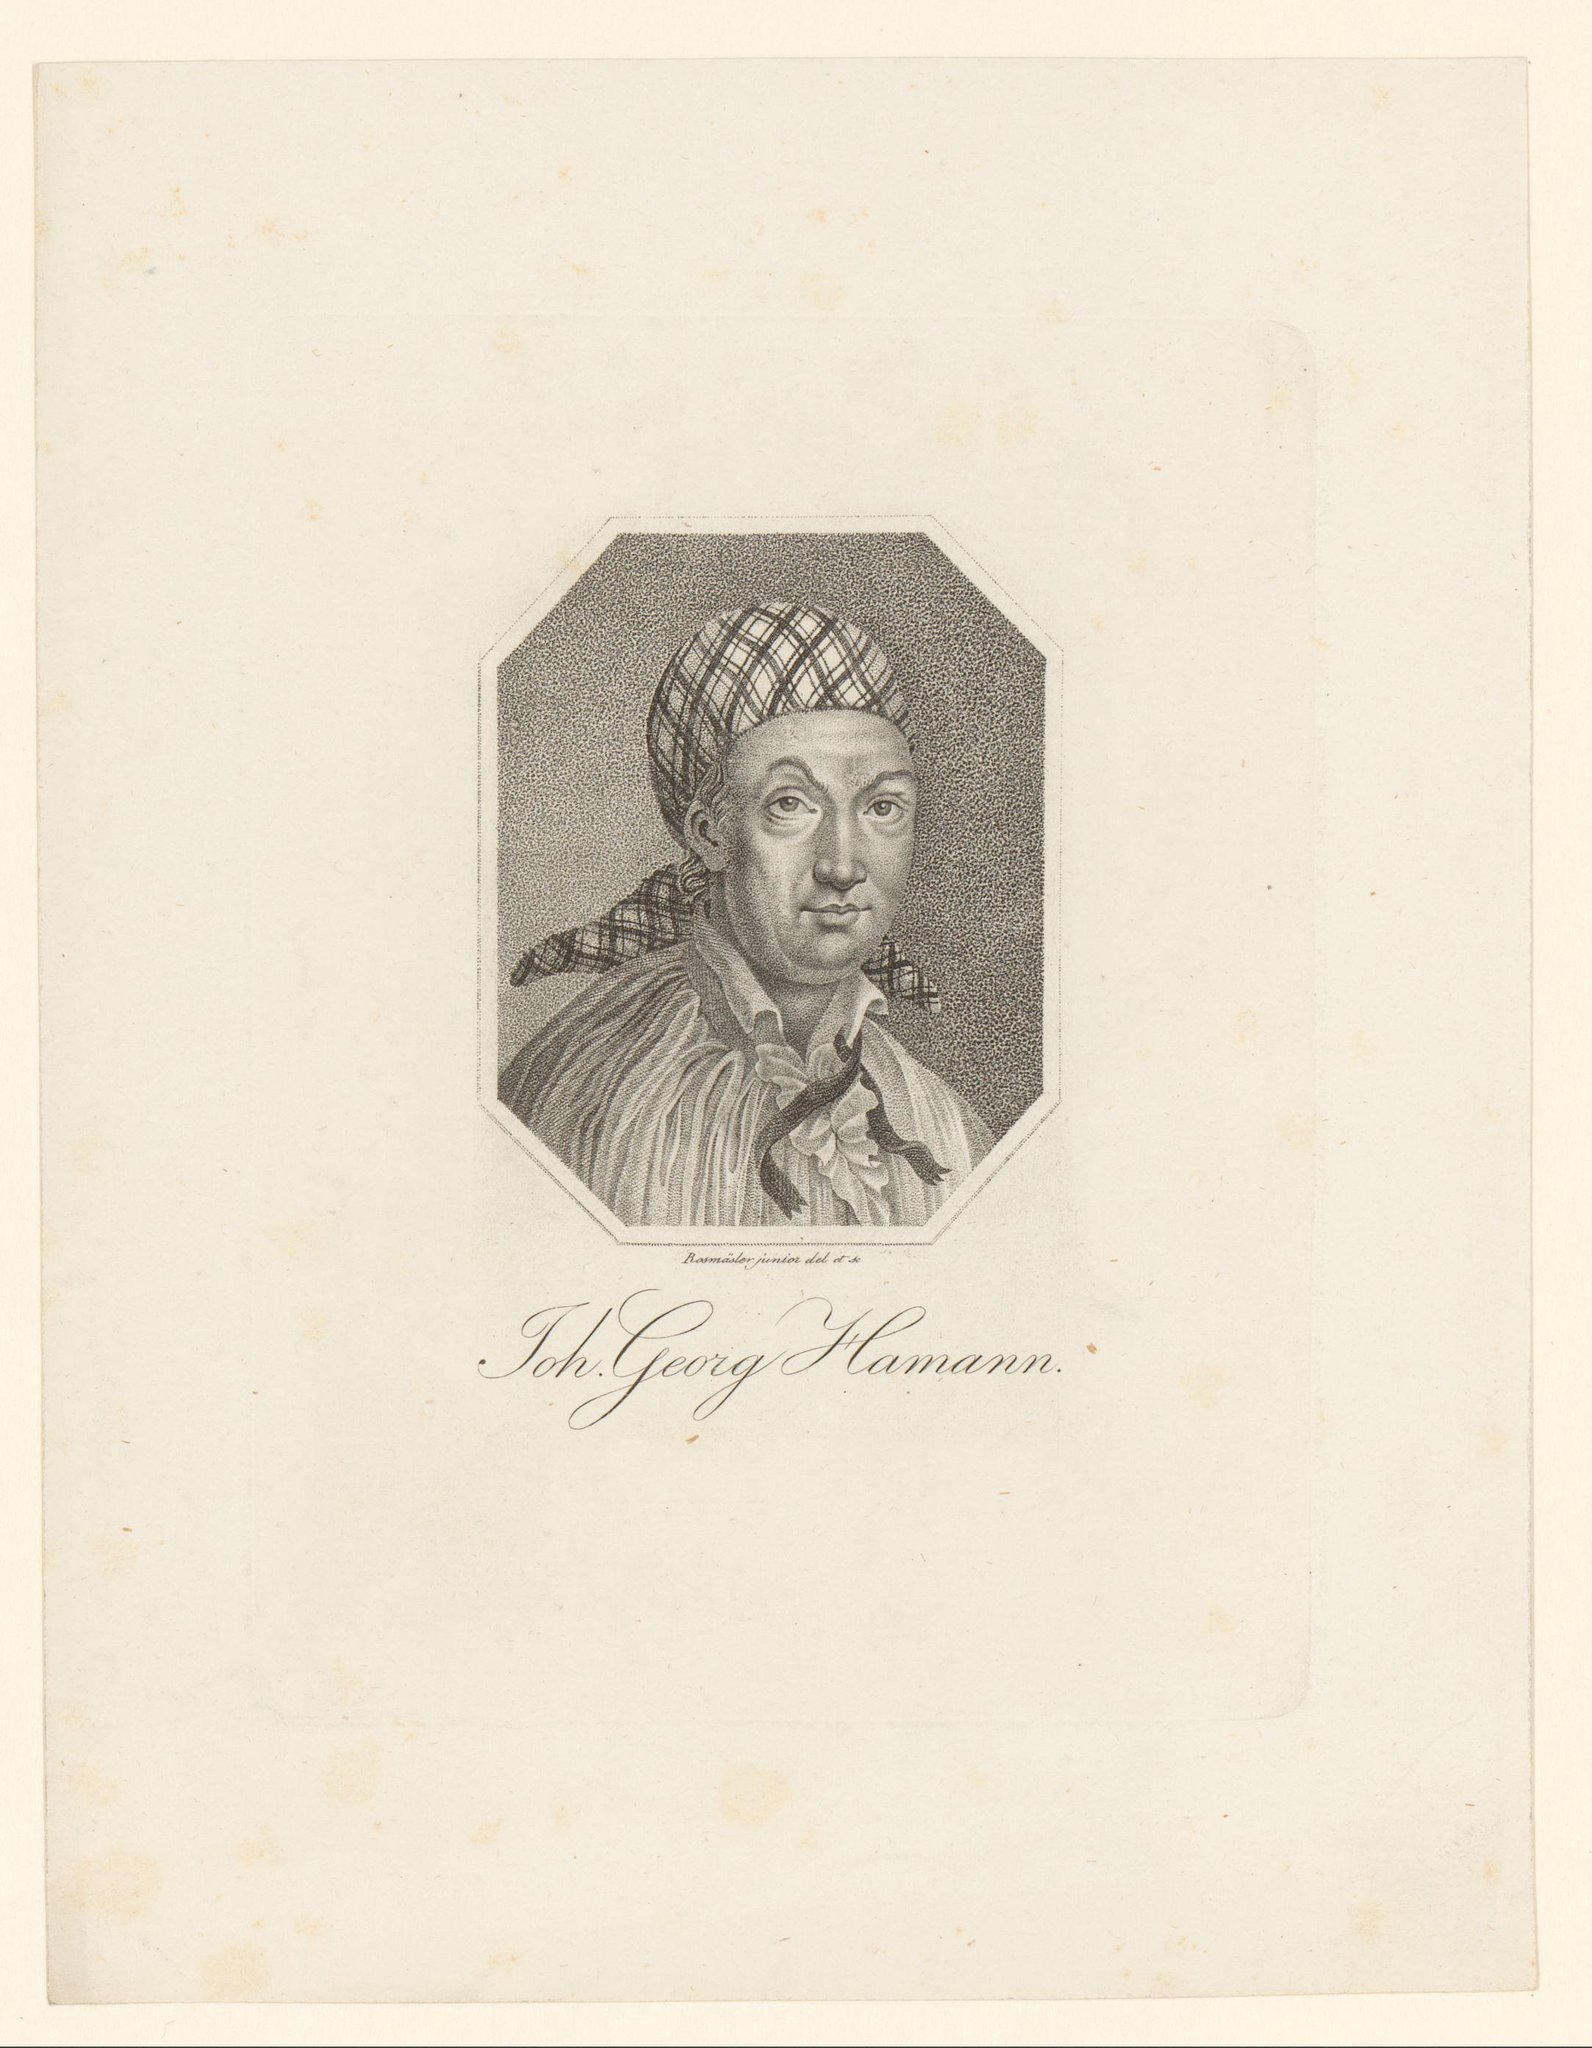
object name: print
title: Portret van Johann Georg Hamann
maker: friedrich rossmässler junior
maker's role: artist, print maker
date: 1785-1858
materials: paper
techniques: engraving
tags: historical persons, writer, poet, author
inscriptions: collector's mark: Lugt 2228